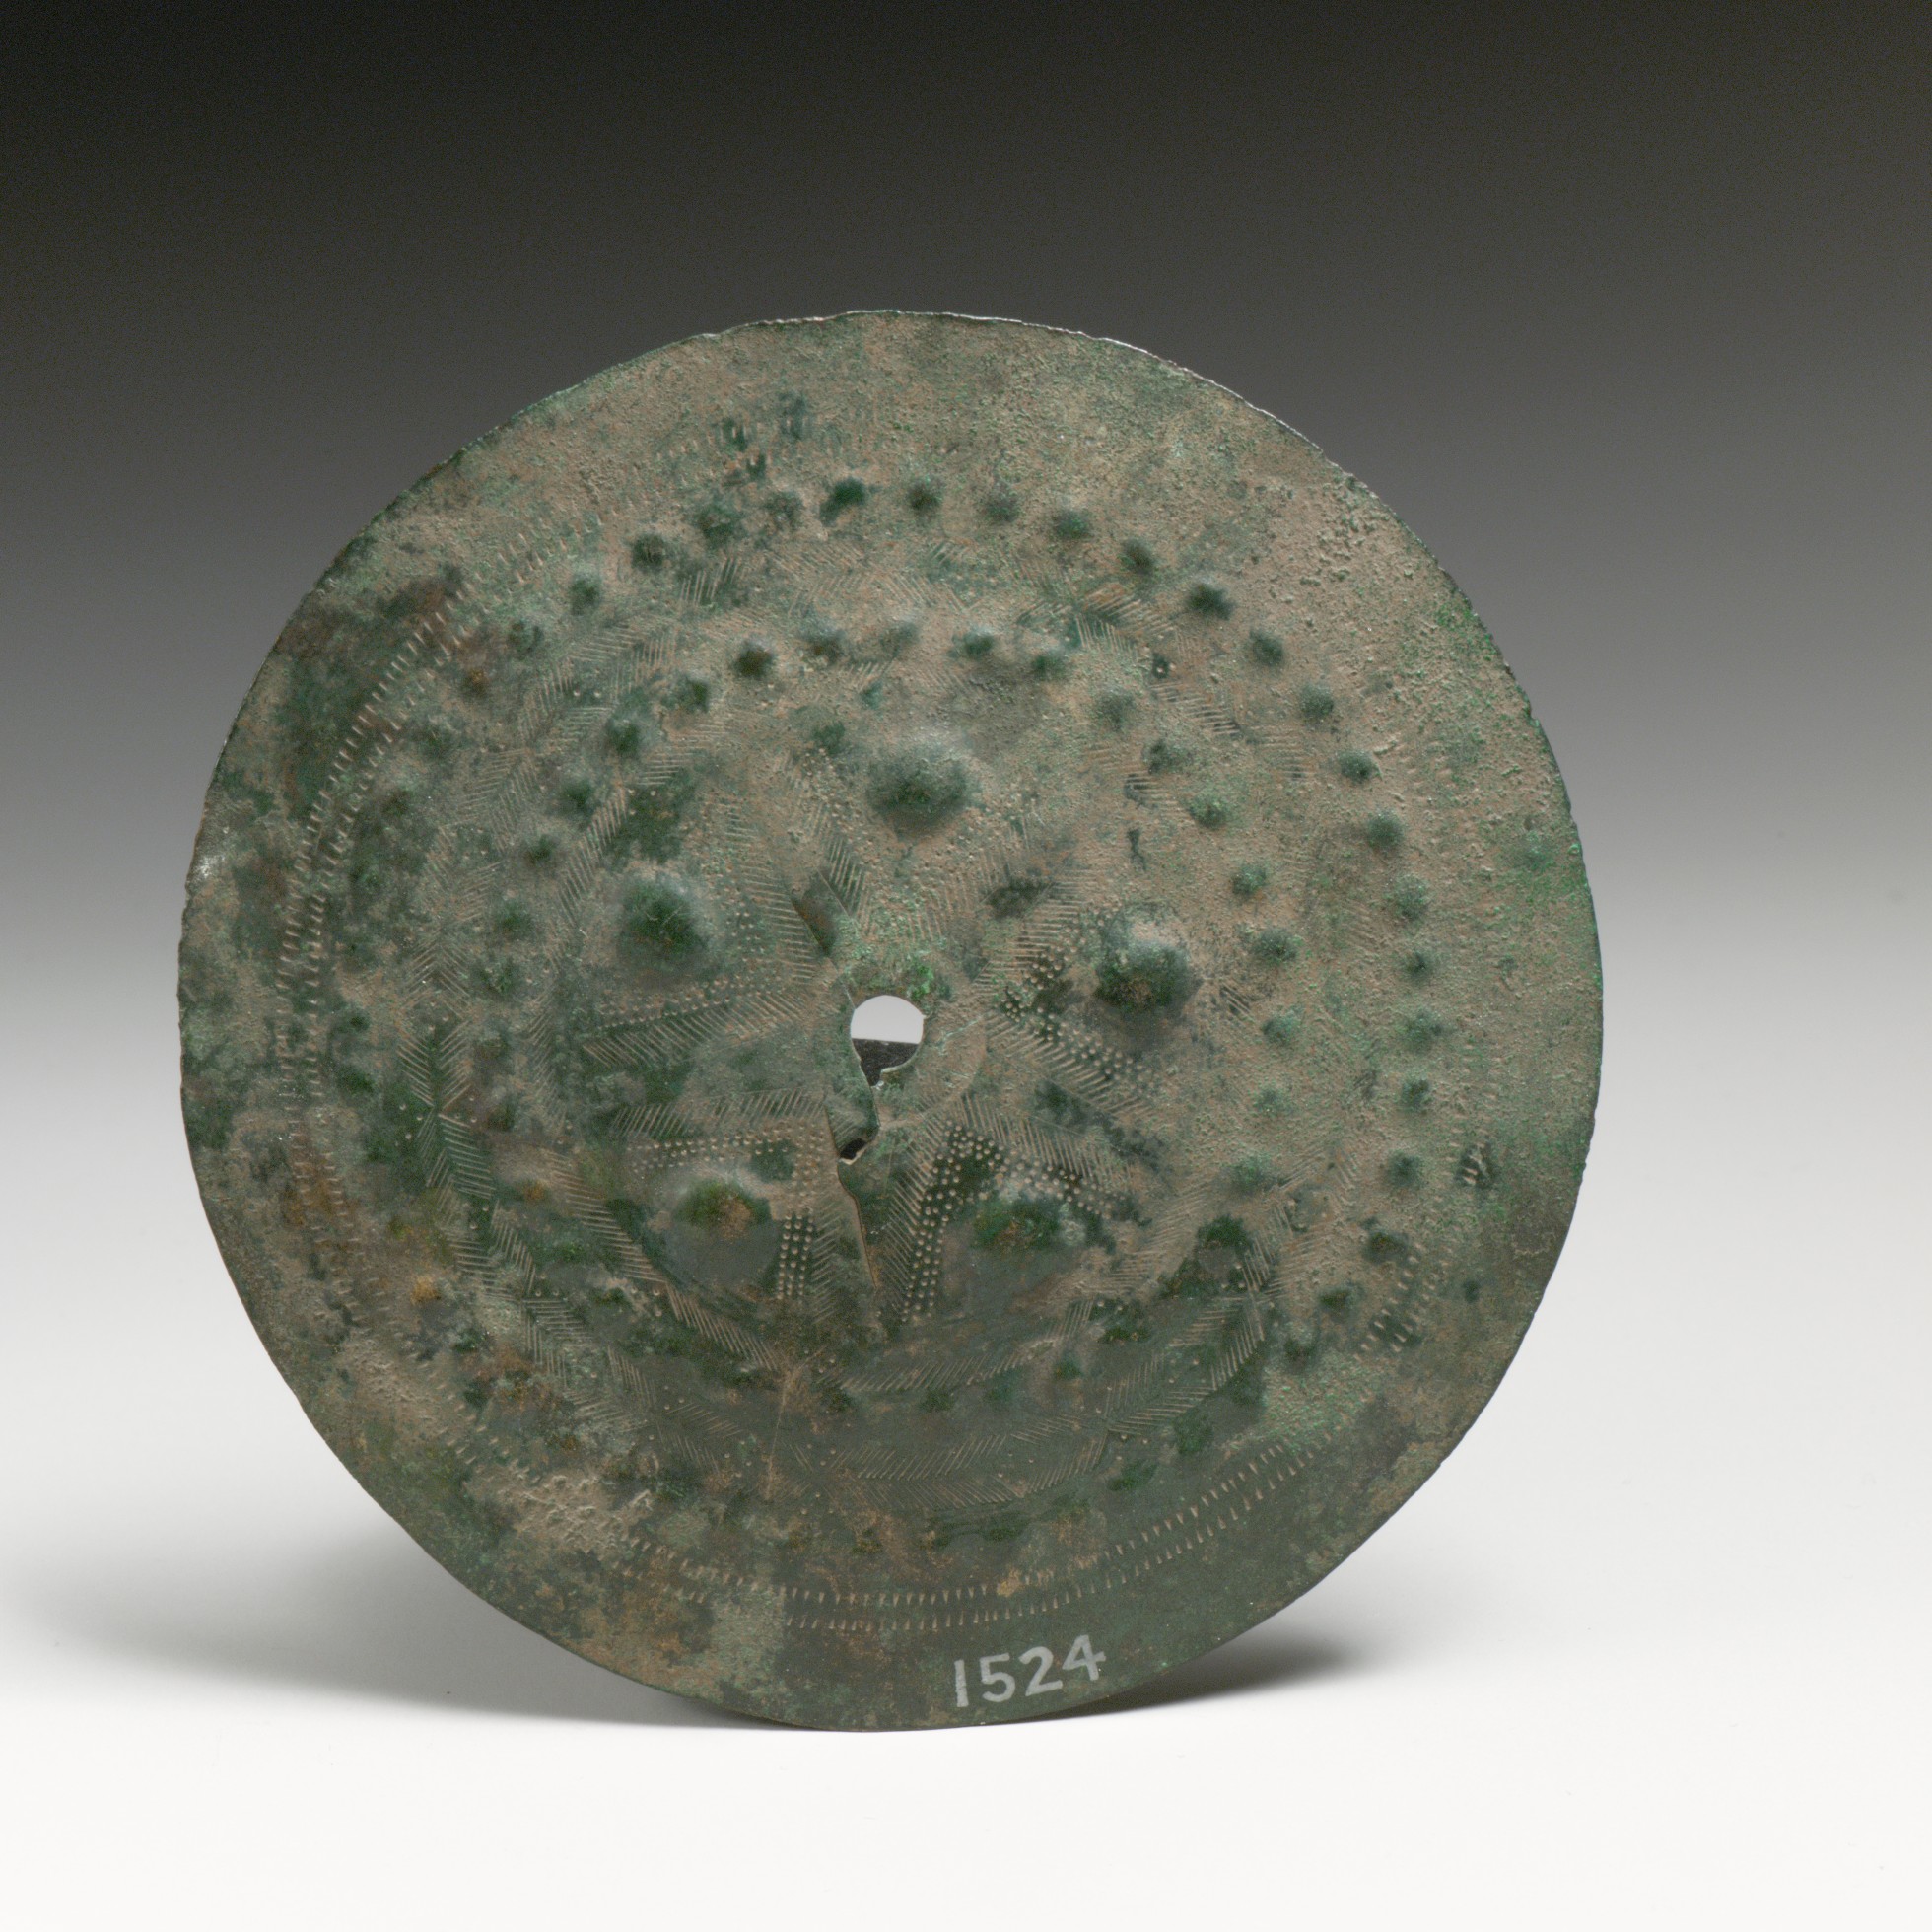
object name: disk, a shield bos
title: Bronze shield boss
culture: etruscan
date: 700-601 BCE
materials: bronze